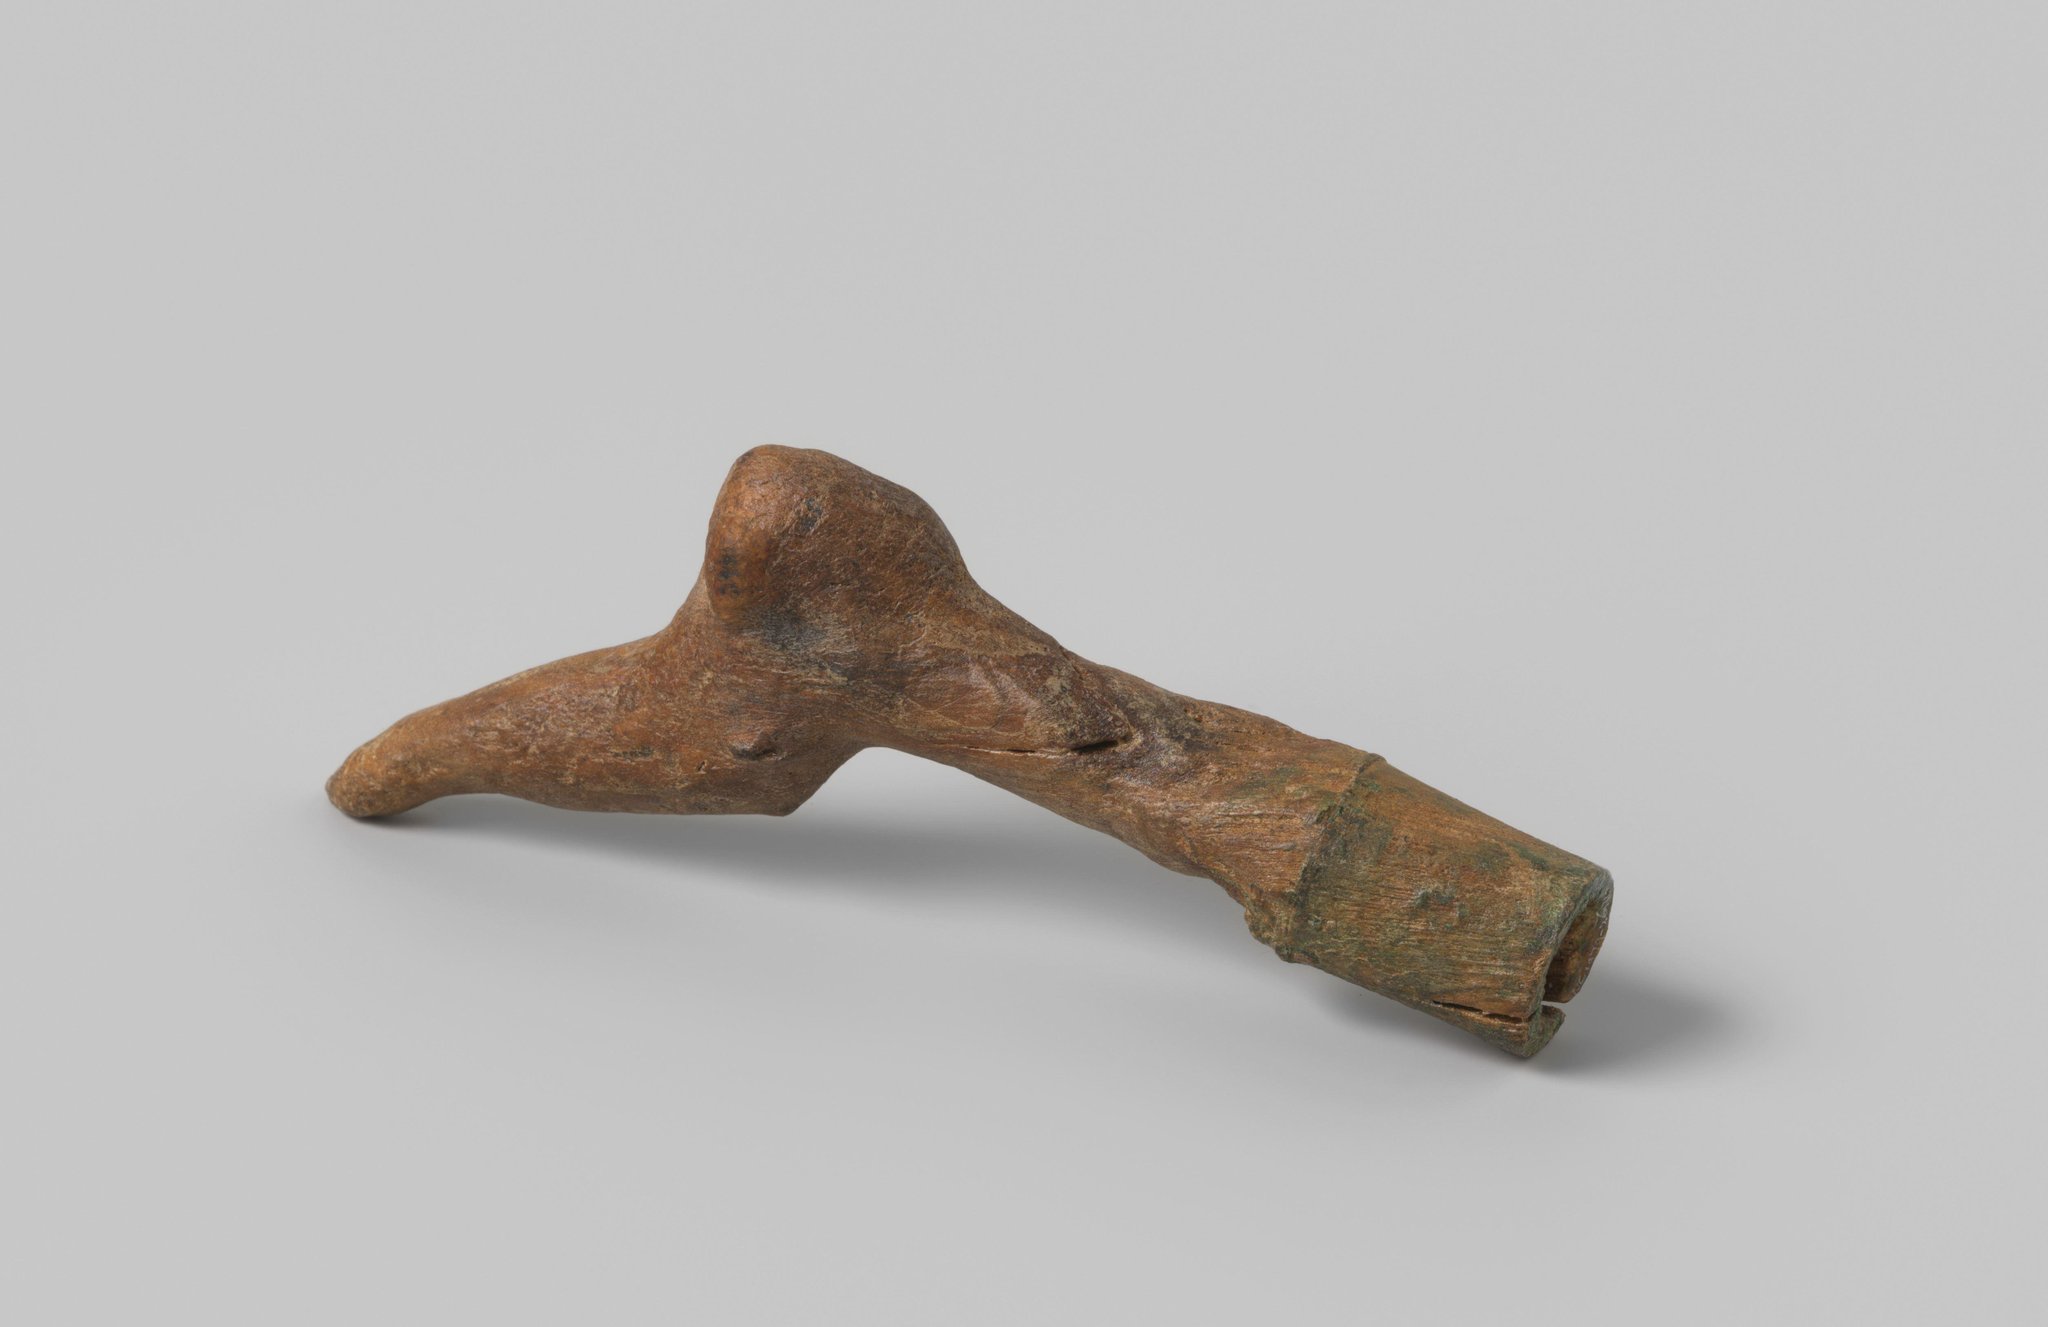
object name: saw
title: Handvat van zaag uit het wrak van de Oost-Indiëvaarder Hollandia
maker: Anonymous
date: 1700-1743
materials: wood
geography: netherlands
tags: verenigde oostindische compagnie, hollandia (schip), annet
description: Saw, naturally grown grip, eroded: butt-shaped front tapering, circular in section, with imprint of ferrule, rectangular tang-hole.